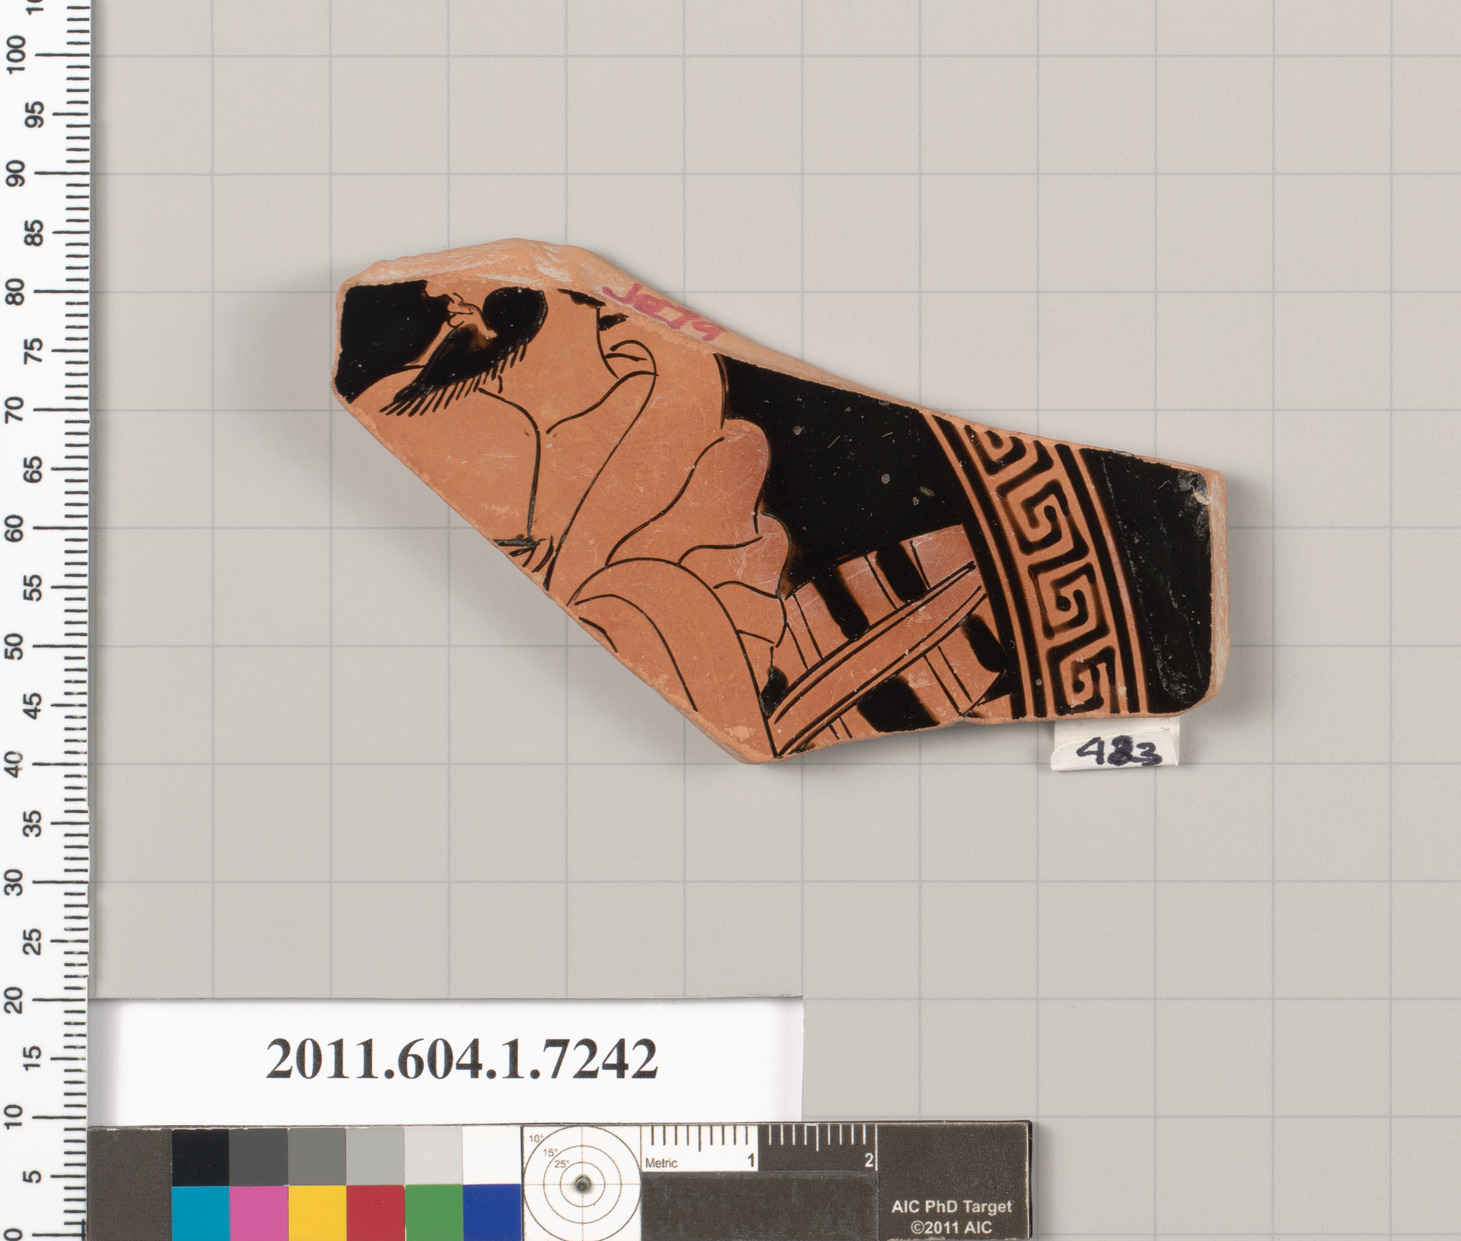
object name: kylix fragment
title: Terracotta fragment of a kylix (drinking cup)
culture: greek, attic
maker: makron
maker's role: artist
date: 500-480 BCE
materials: terracotta